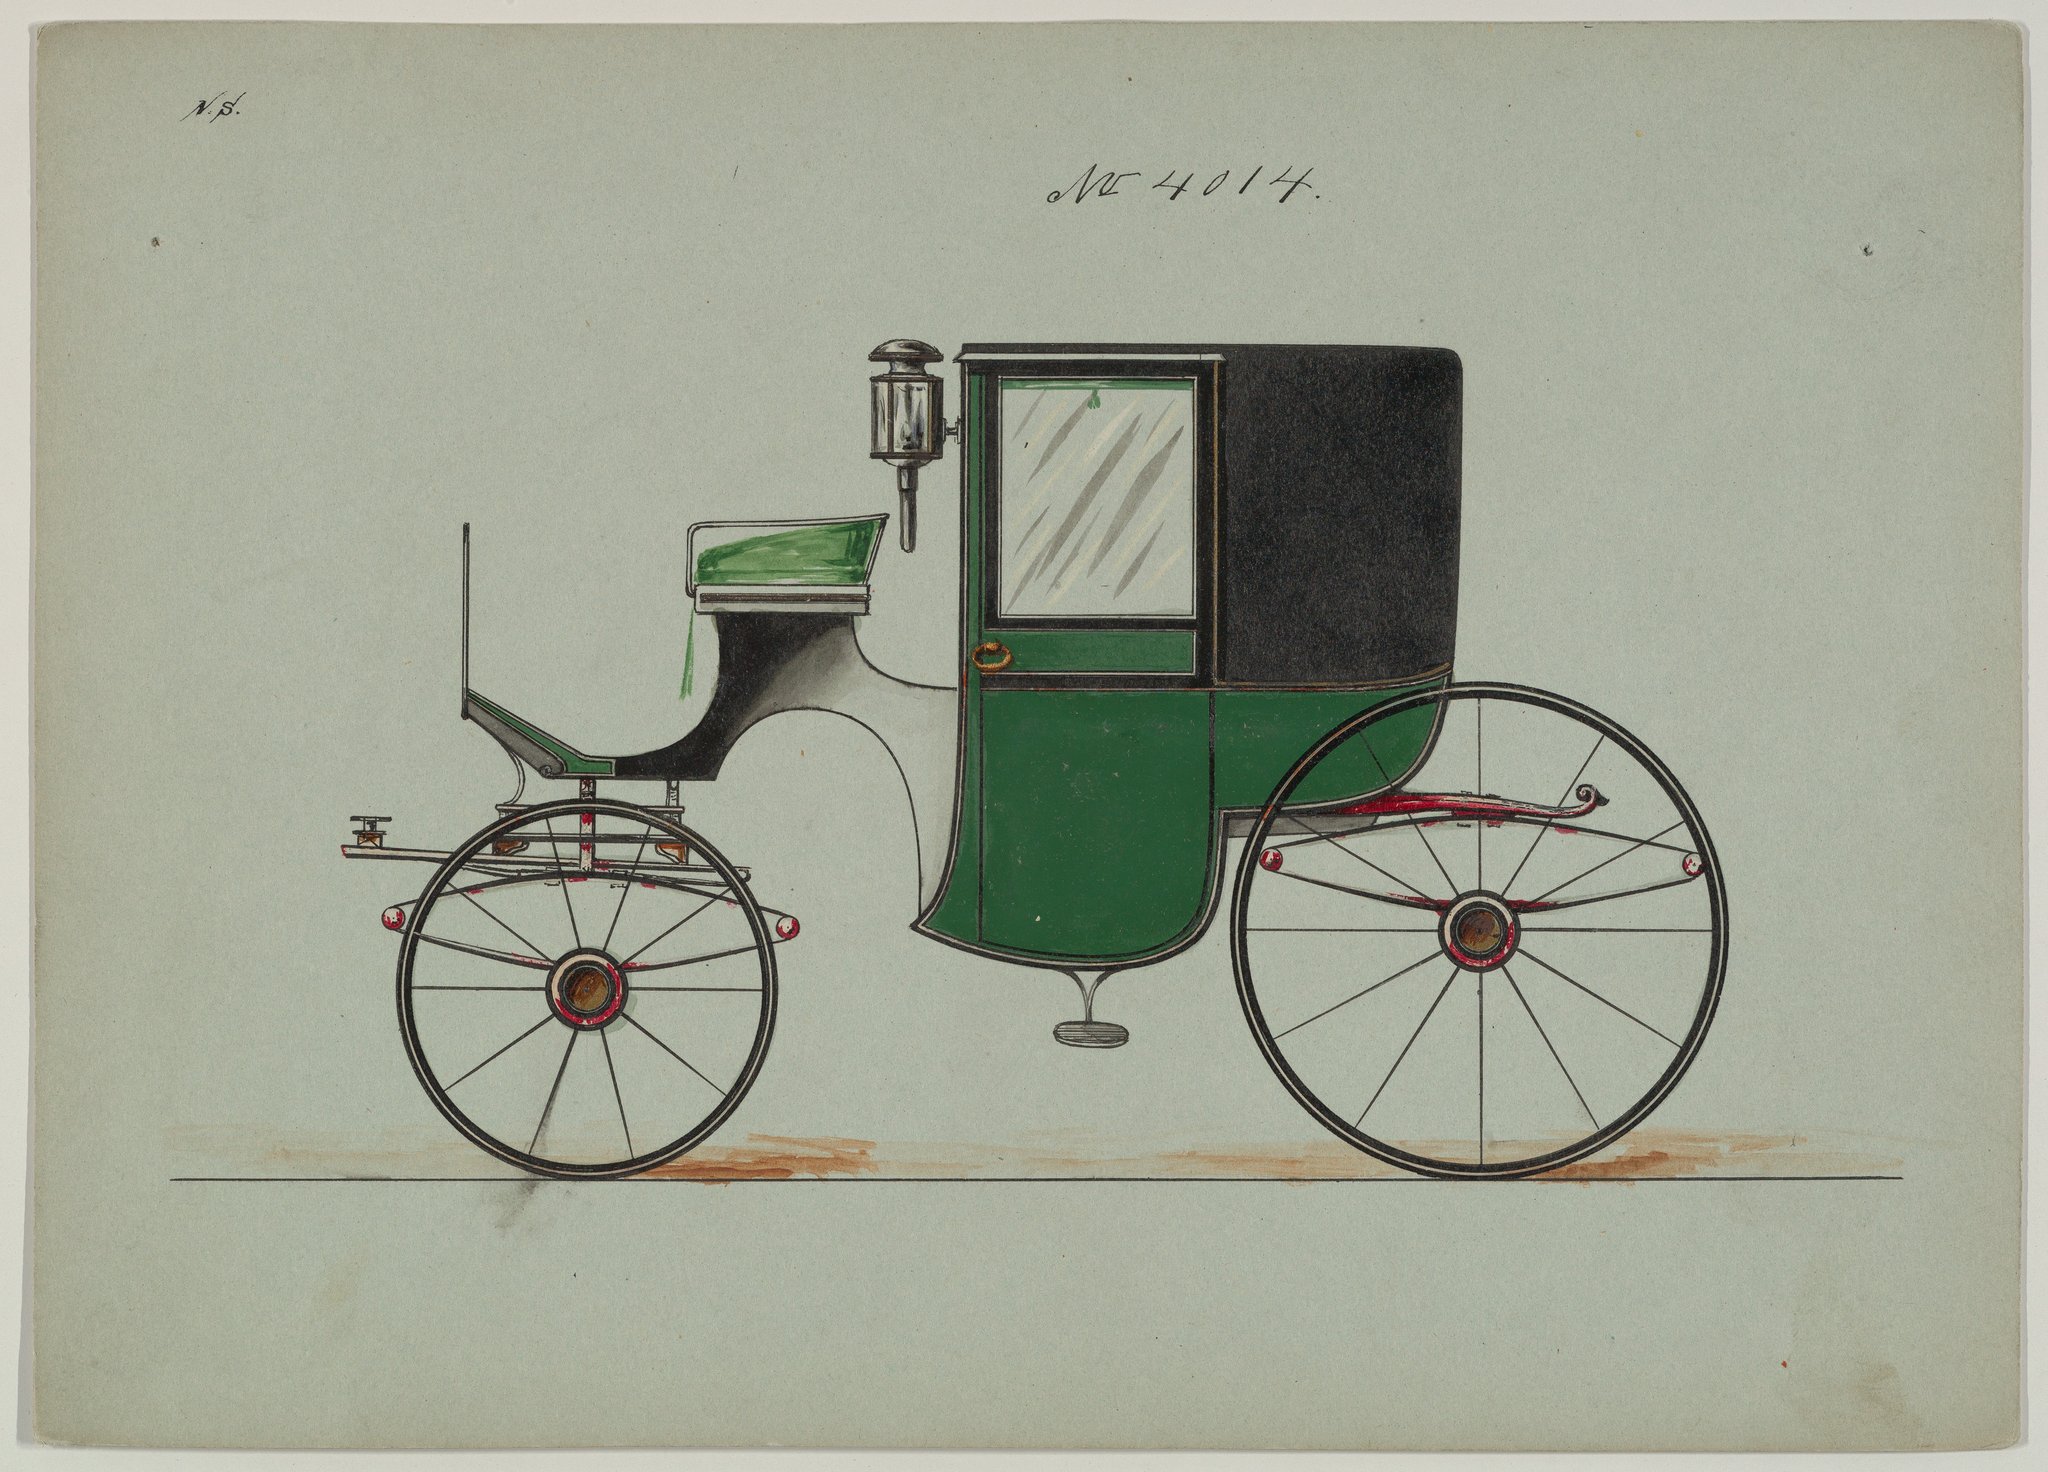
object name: drawing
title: Brougham #4014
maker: brewster & co.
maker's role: manufacturer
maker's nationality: american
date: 1888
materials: gouache, gum arabic, ink, watercolor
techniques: pen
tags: carriages